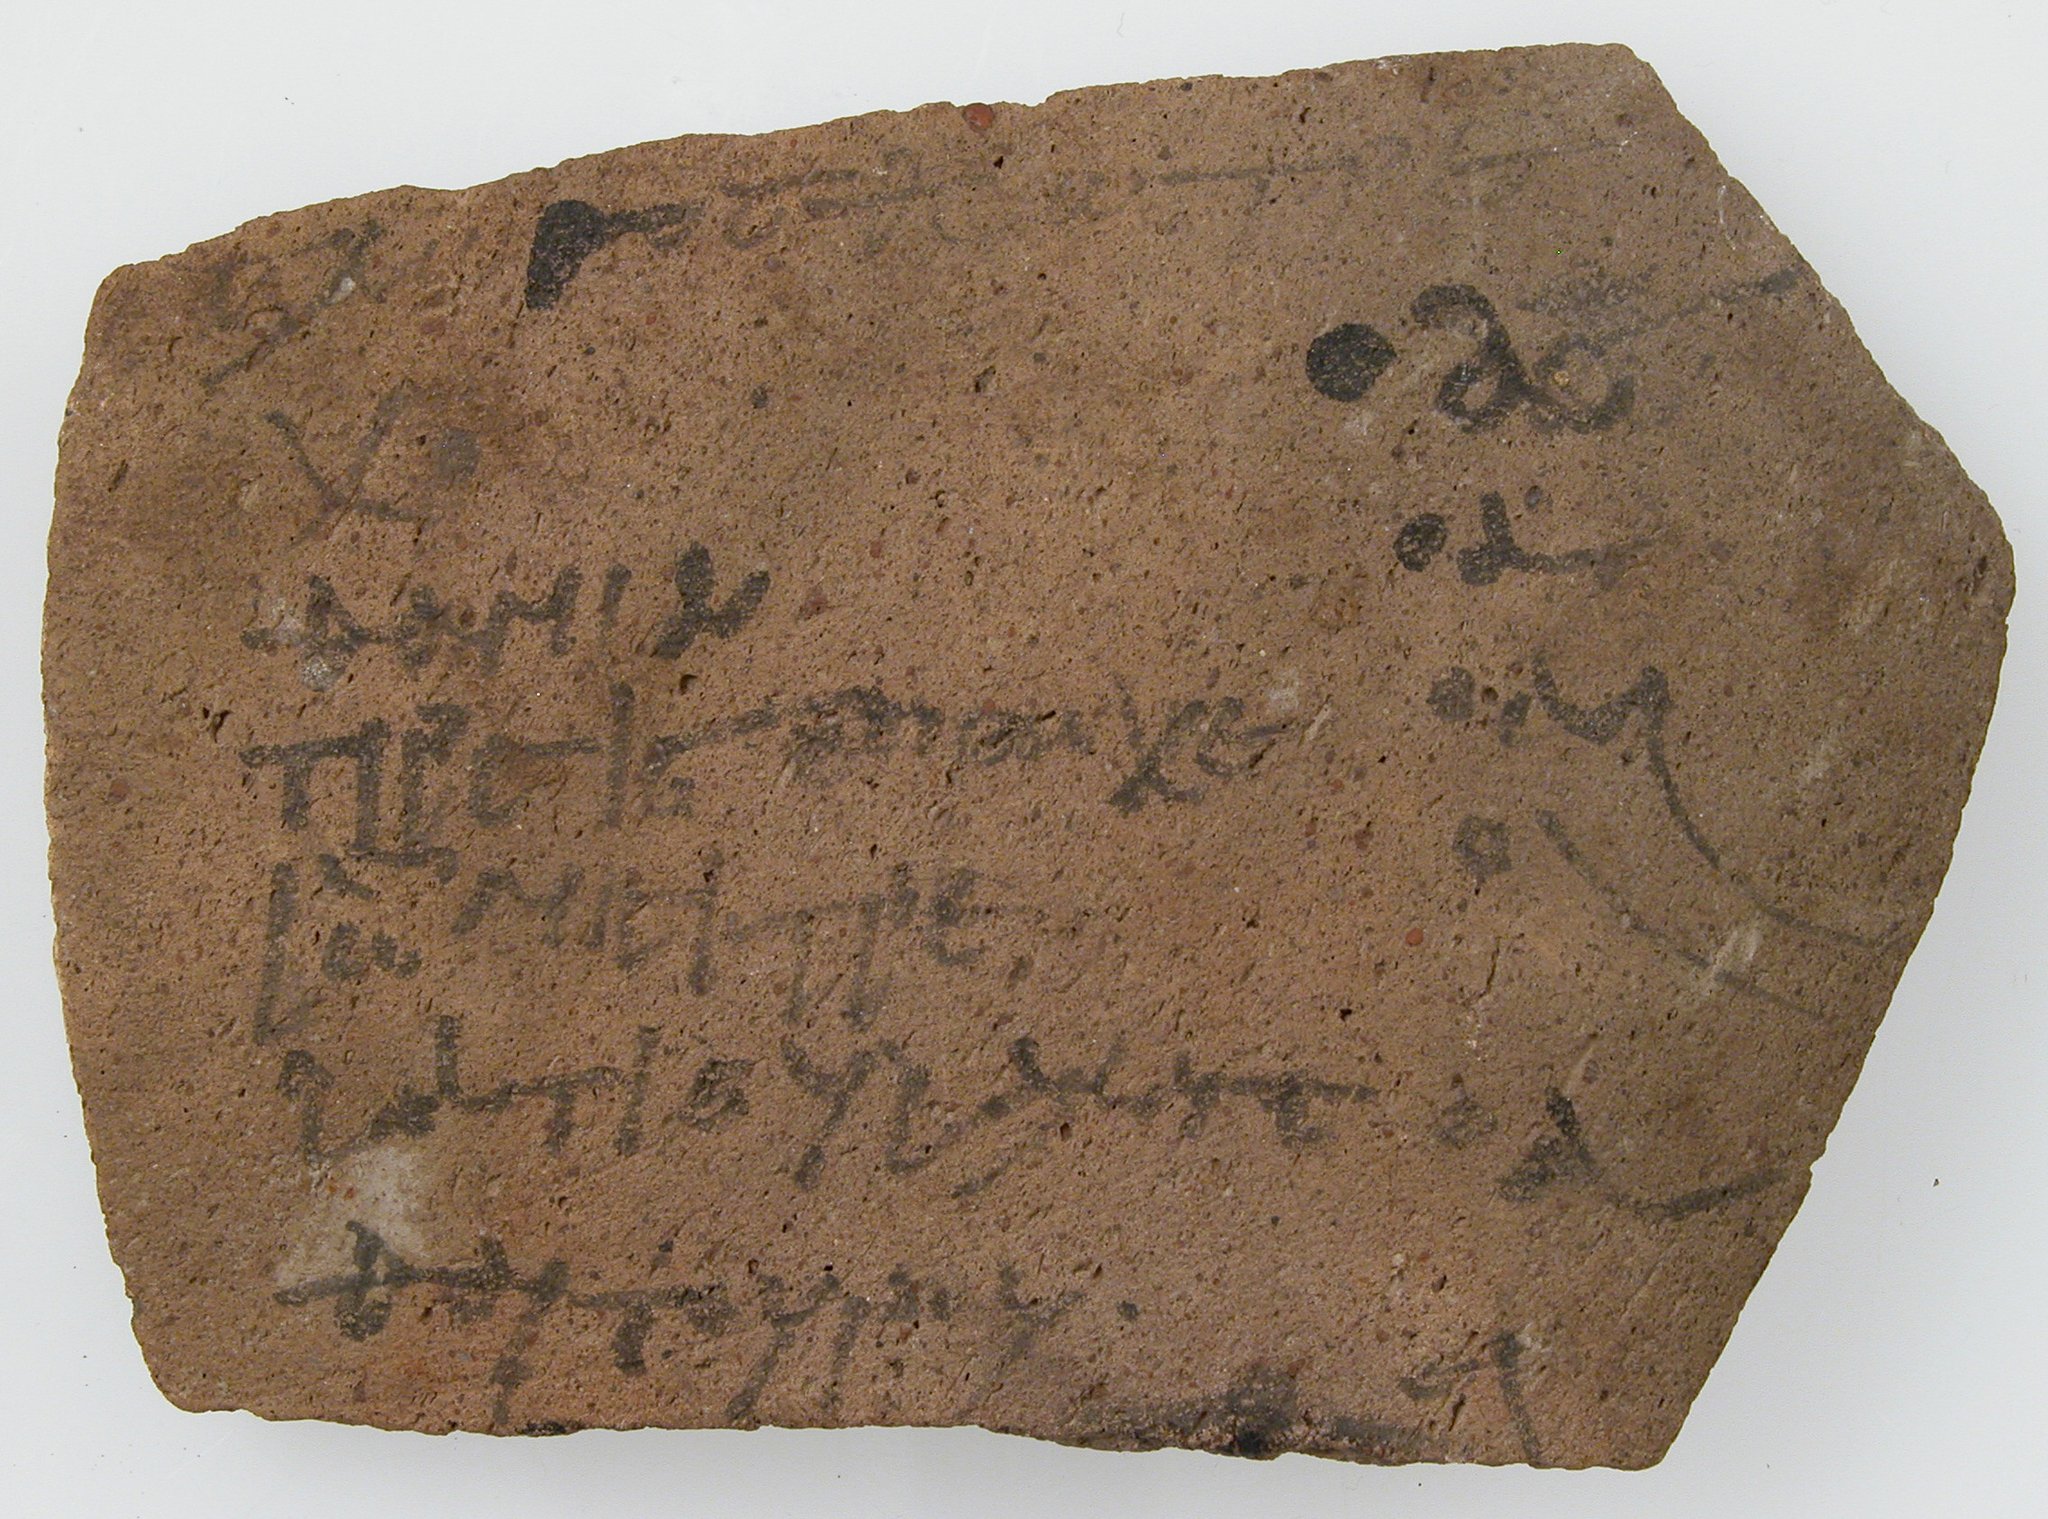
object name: ostrakon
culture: coptic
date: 601-700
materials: ink, pottery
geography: egypt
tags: coptic,documents